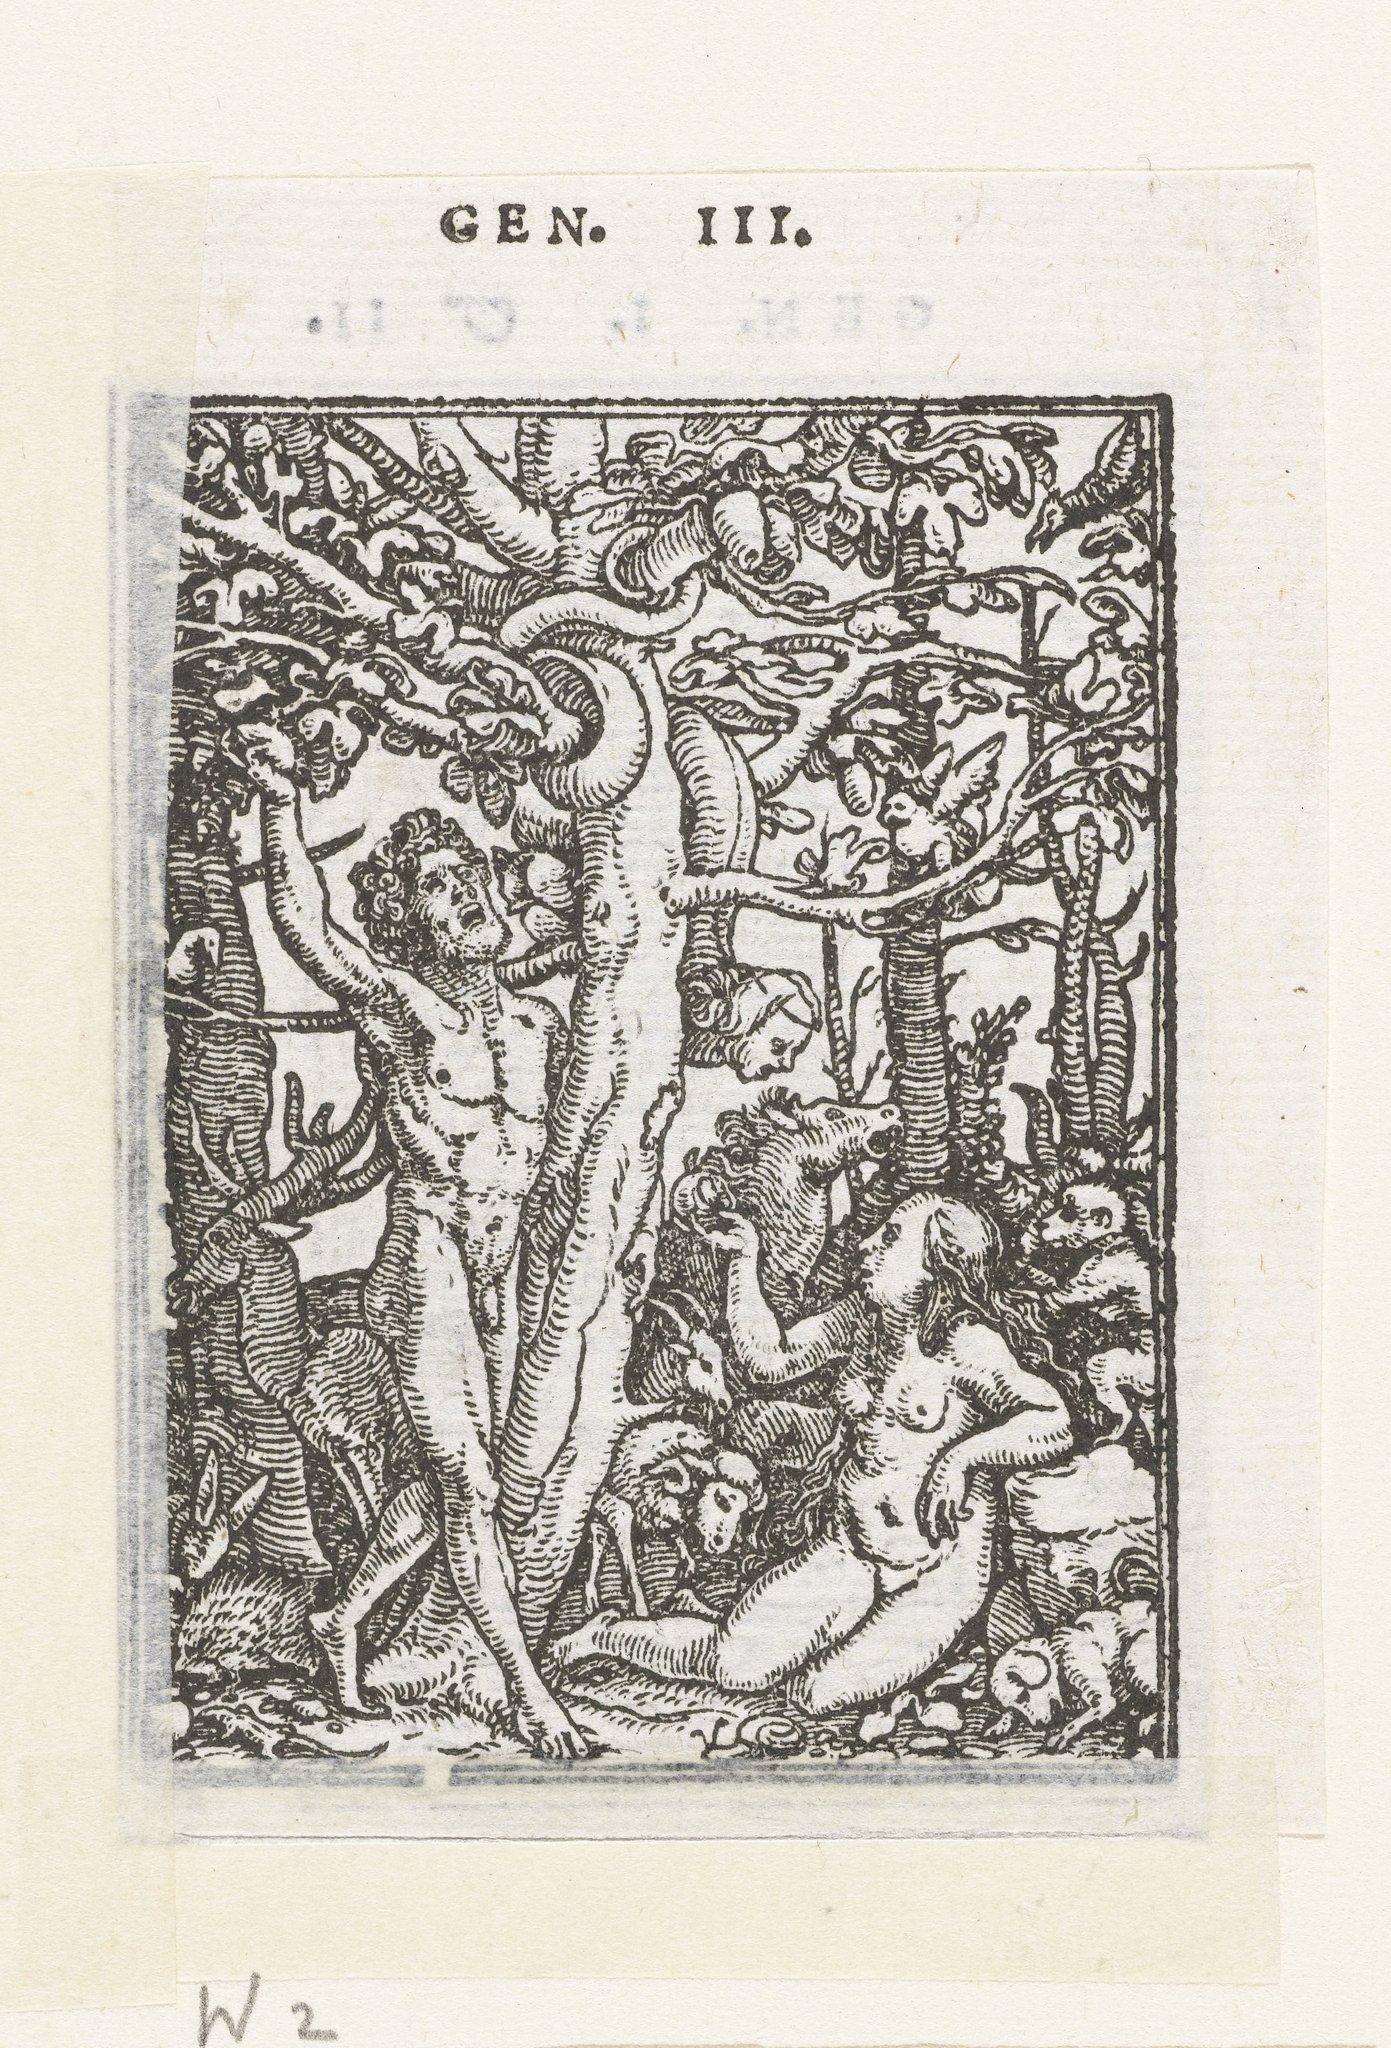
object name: print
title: Dodendans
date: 1524-1526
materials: paper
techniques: woodcut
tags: temptation and fall (scenes with both adam and eve)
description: De houtblokken werden voor 1526 vervaardigd door Hans Lützelburg en pas in 1538 voor het eerst gebruikt als boekillustraties in: Les simulachres & historiees faces de la mort avtant elegamment pourtraictes que artificiellement imaginées... a Lyon, Soubsz l'escu de Coloigne, MDXXXVIII, (M. en G. Trechsel, voor F. Frellon in Lyon), 1538. Later verschenen nog andere uitgaven.